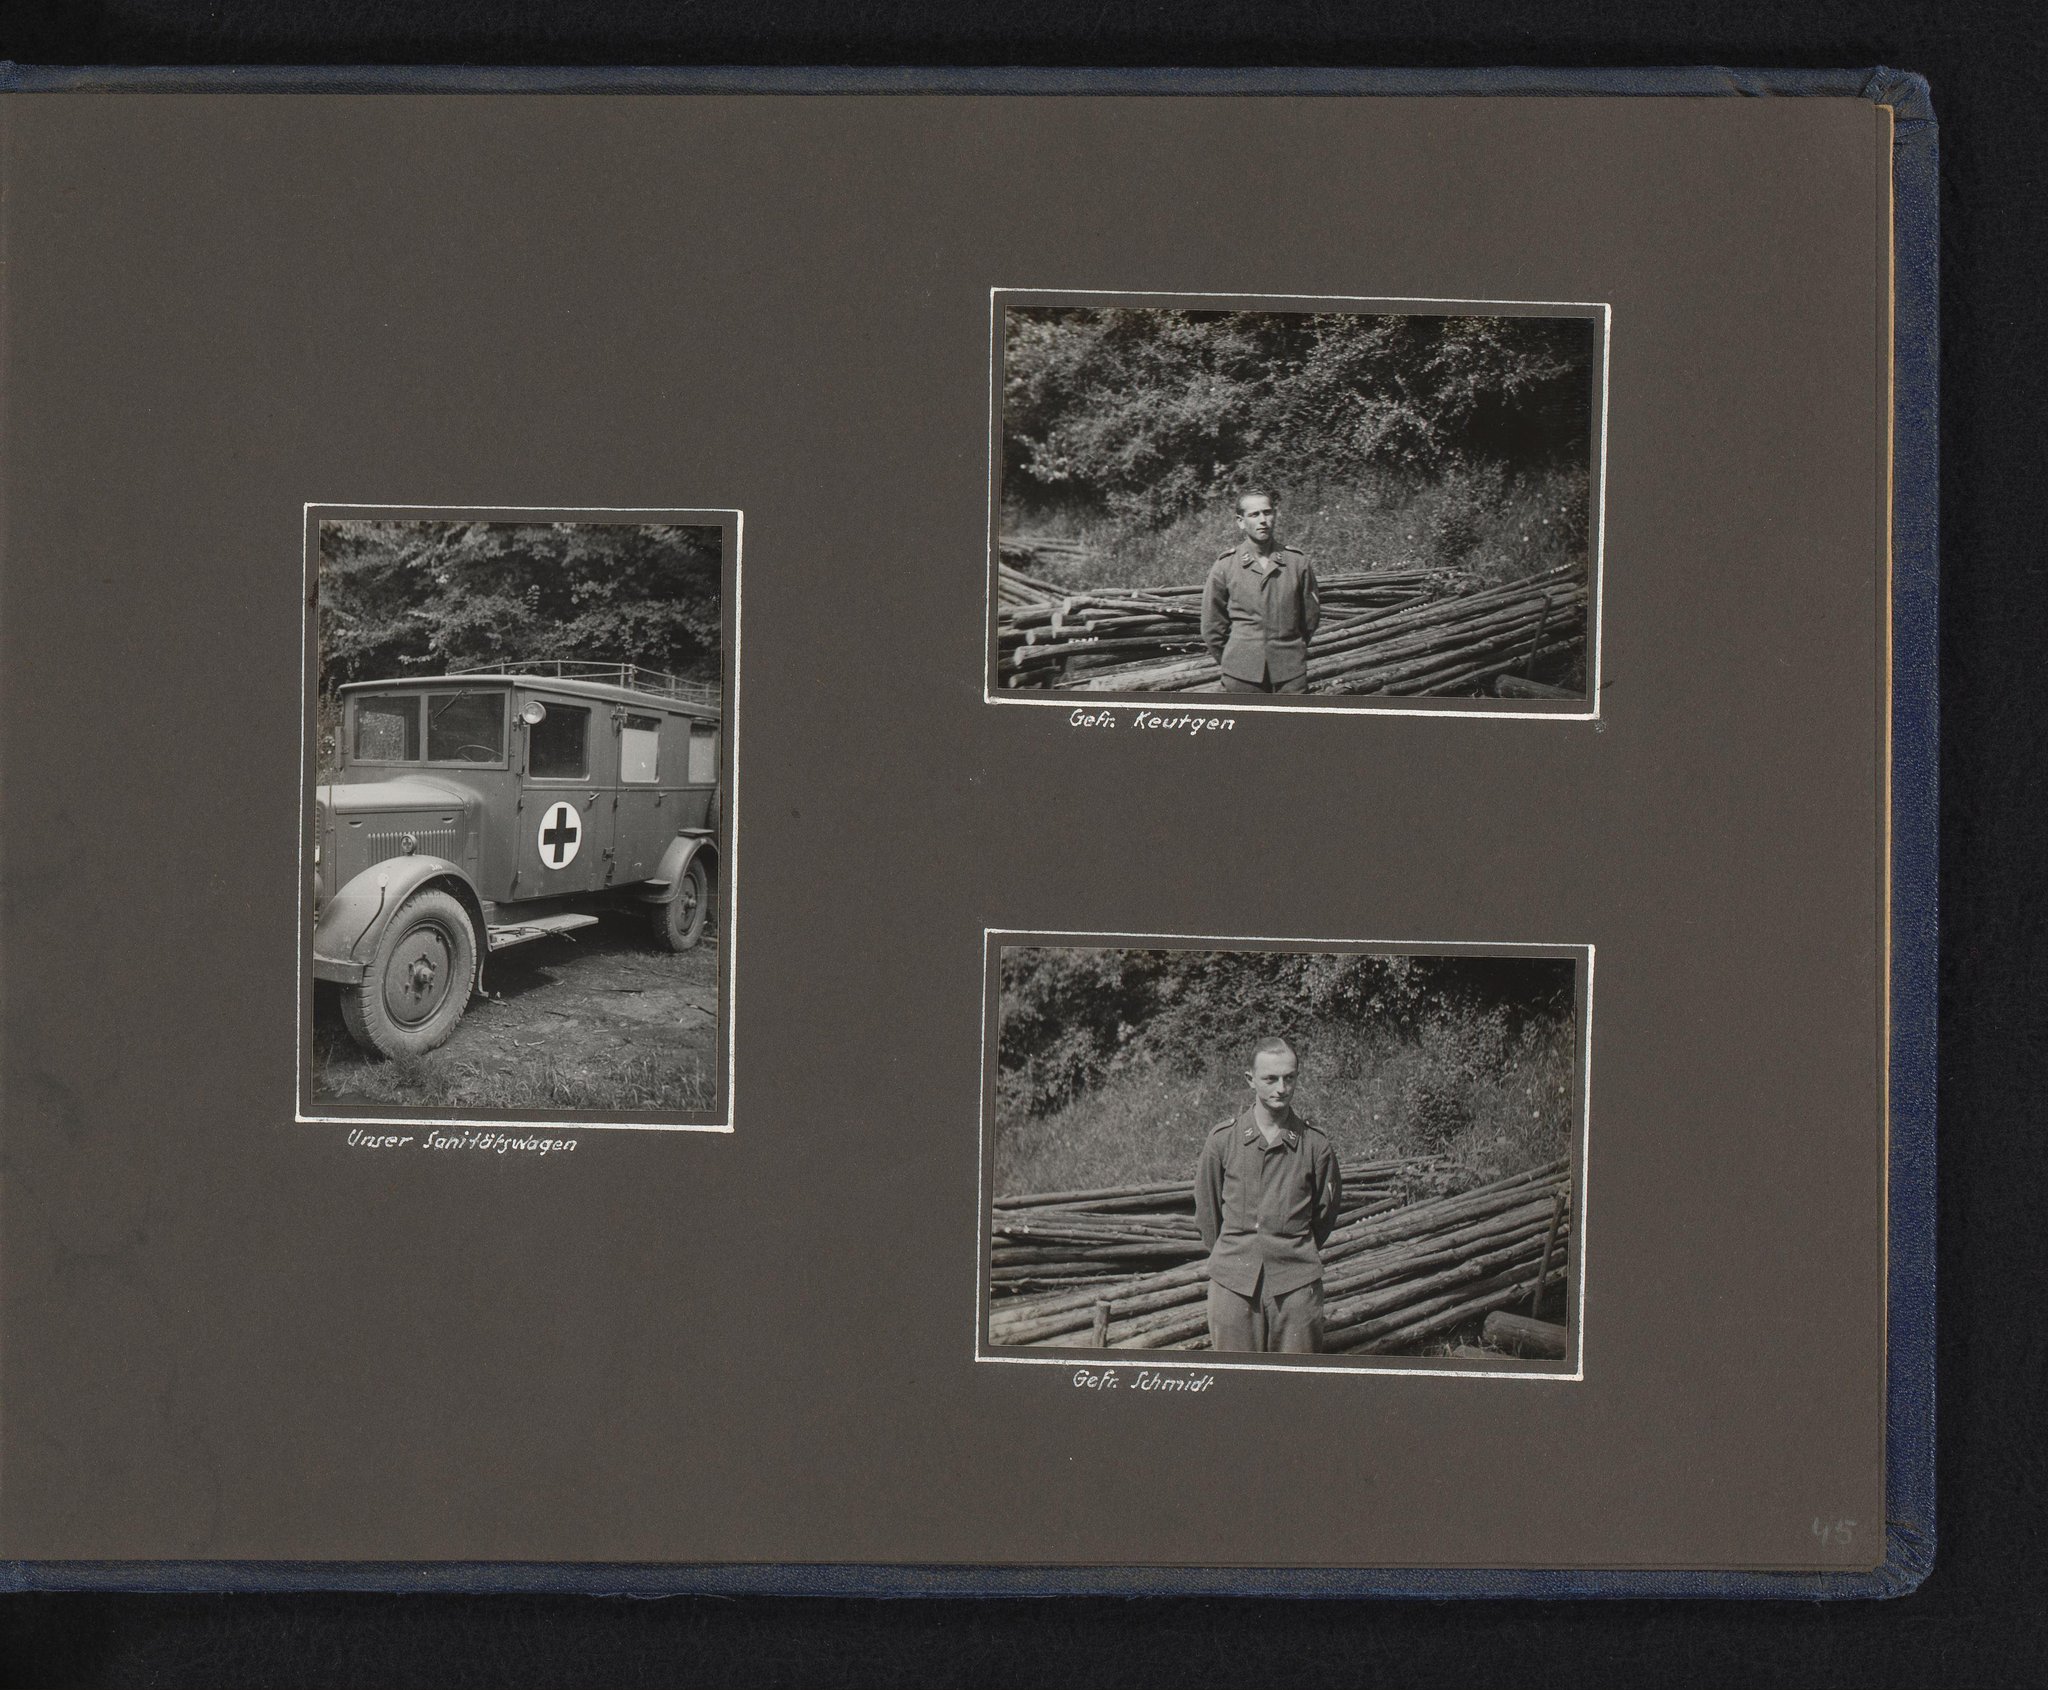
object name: photograph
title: Militairen en ziekenwagen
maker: Anonymous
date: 1940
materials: paper, photographic support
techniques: gelatin silver print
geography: germany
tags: the company, the unit, the troop ~ military service, ambulance, modern forms of military vehicles, germany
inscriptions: inscription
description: Albumblad met drie foto's van een ziekenwagen en portretten van Duitse militairen. Onderdeel van een Duits militair album Tweede Wereldoorlog 1939-1940.